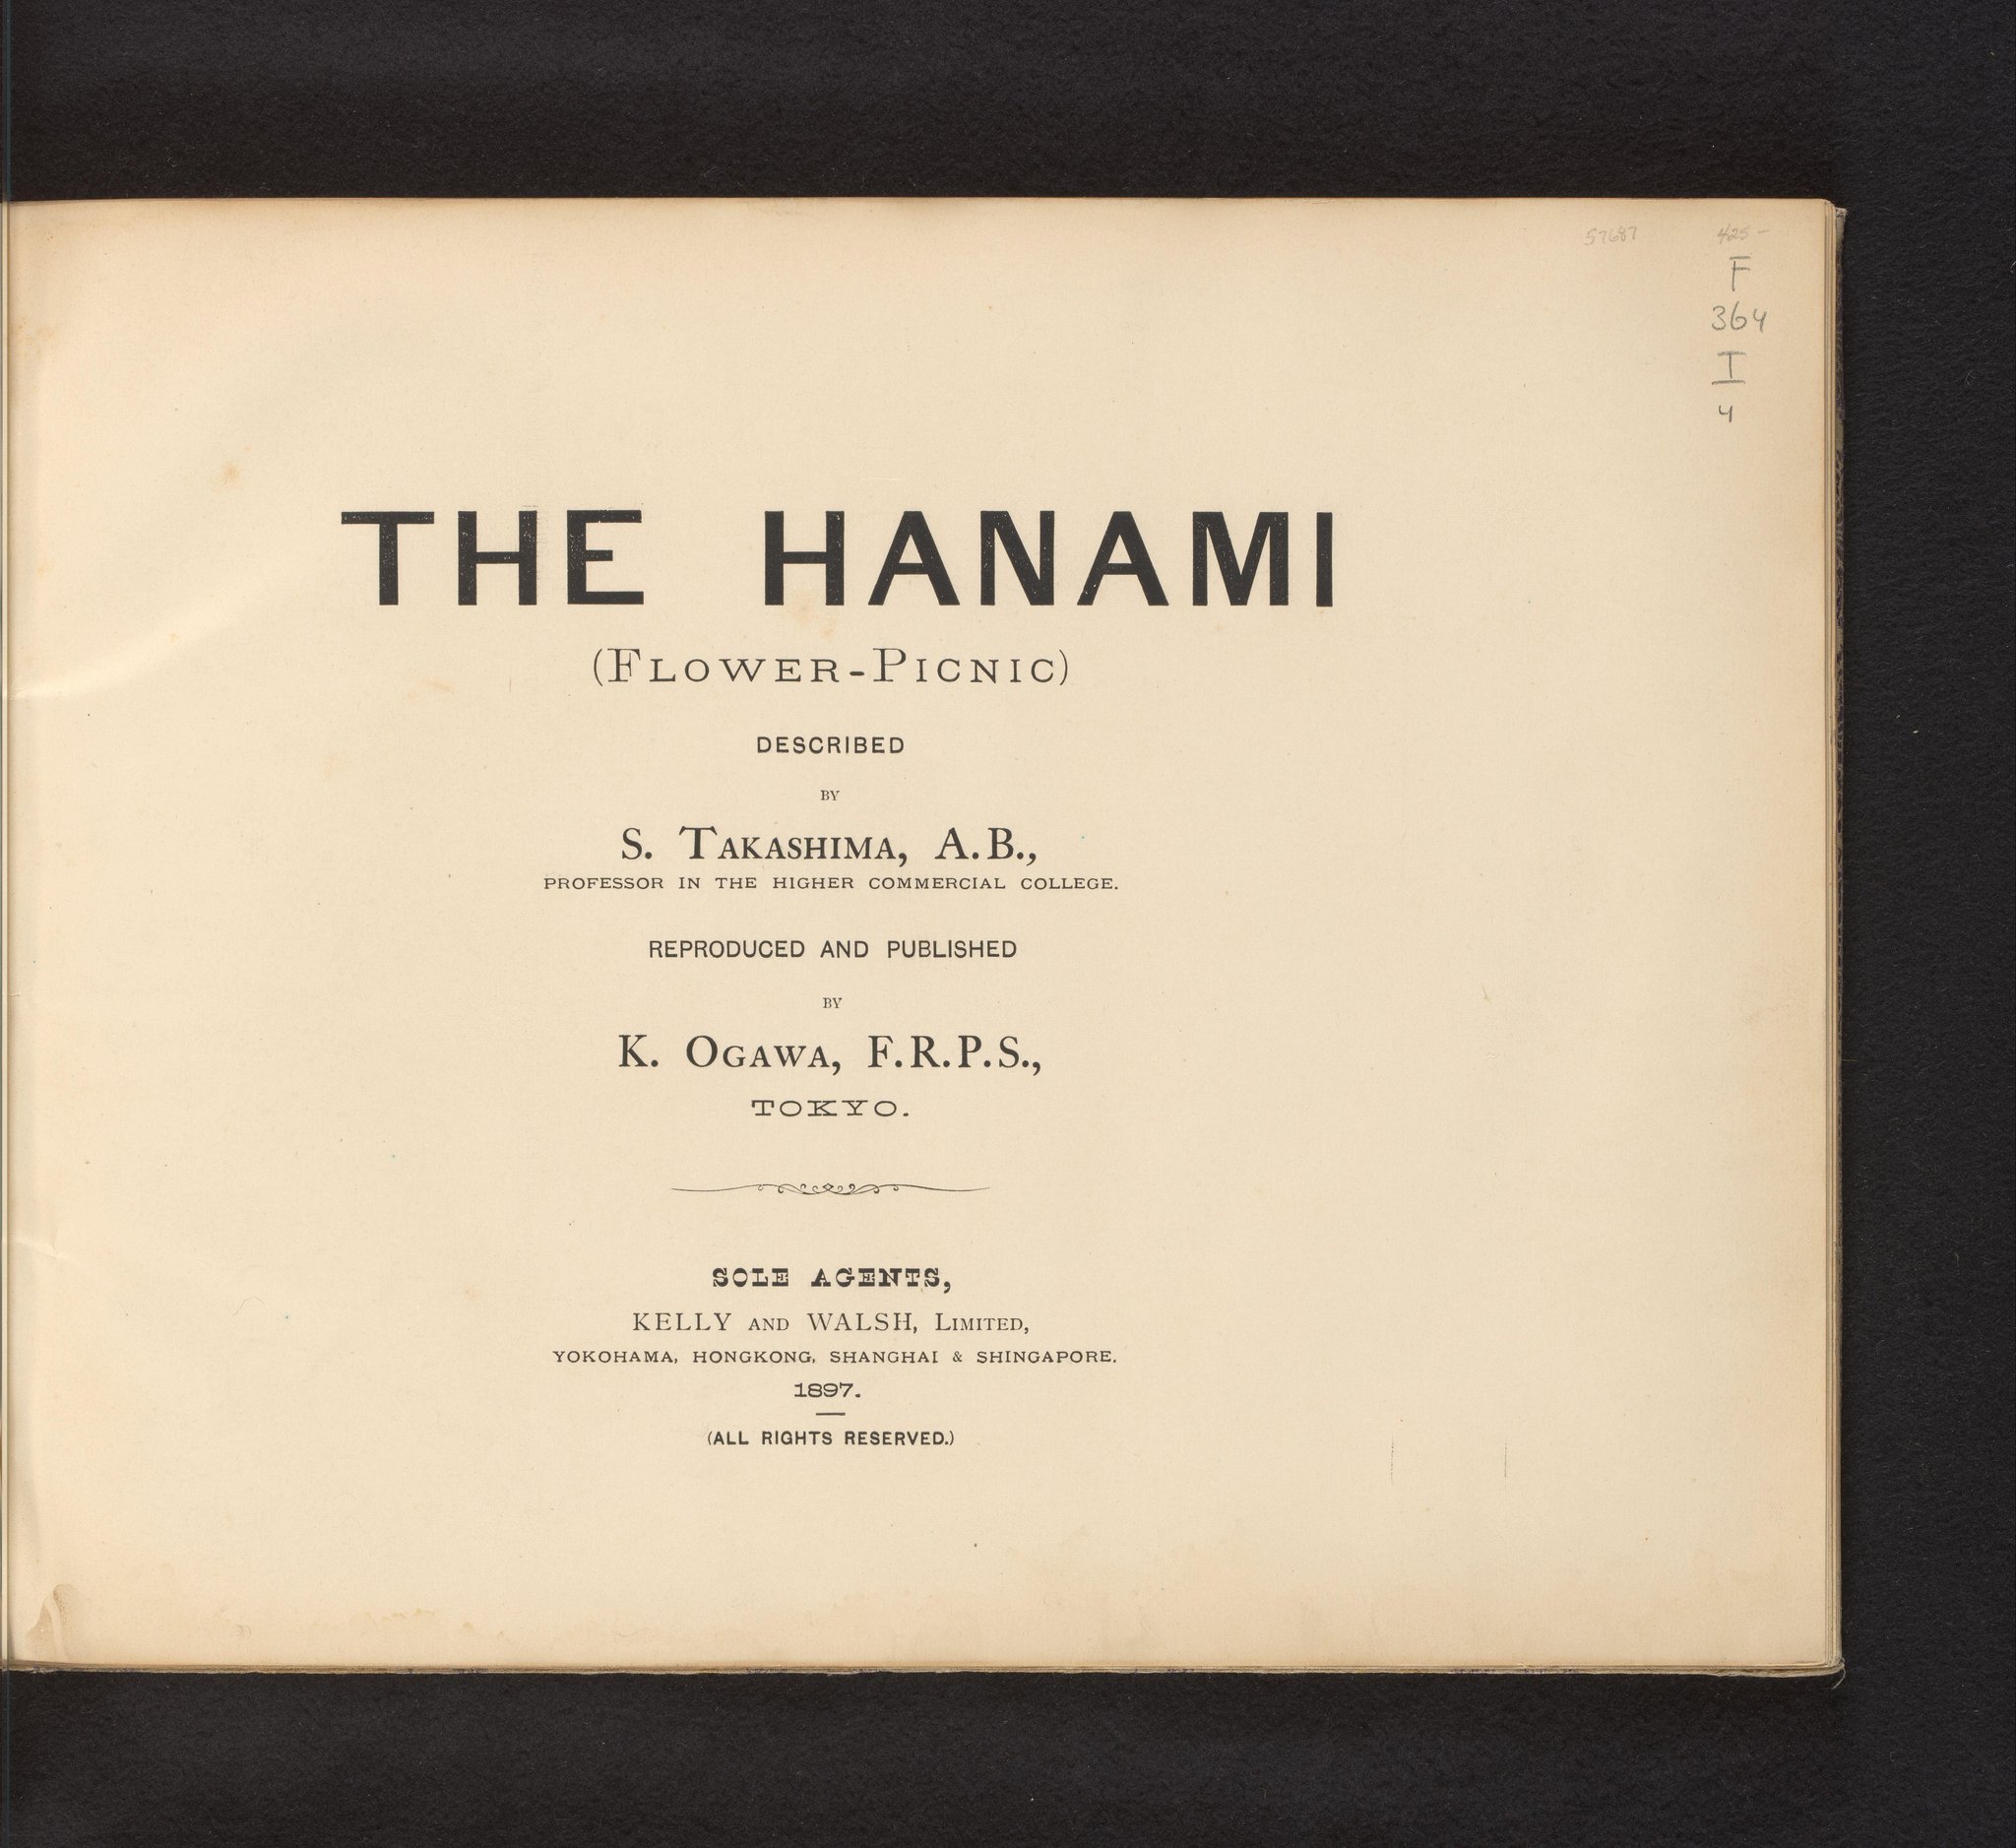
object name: book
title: The Hanami (flower picnic) / descr. by S. Takashima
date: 1897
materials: cardboard, linen, paper, textile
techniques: photograph, decorated paper, hand coloring, printing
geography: tokyo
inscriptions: date: ‘MAR/ 1999’